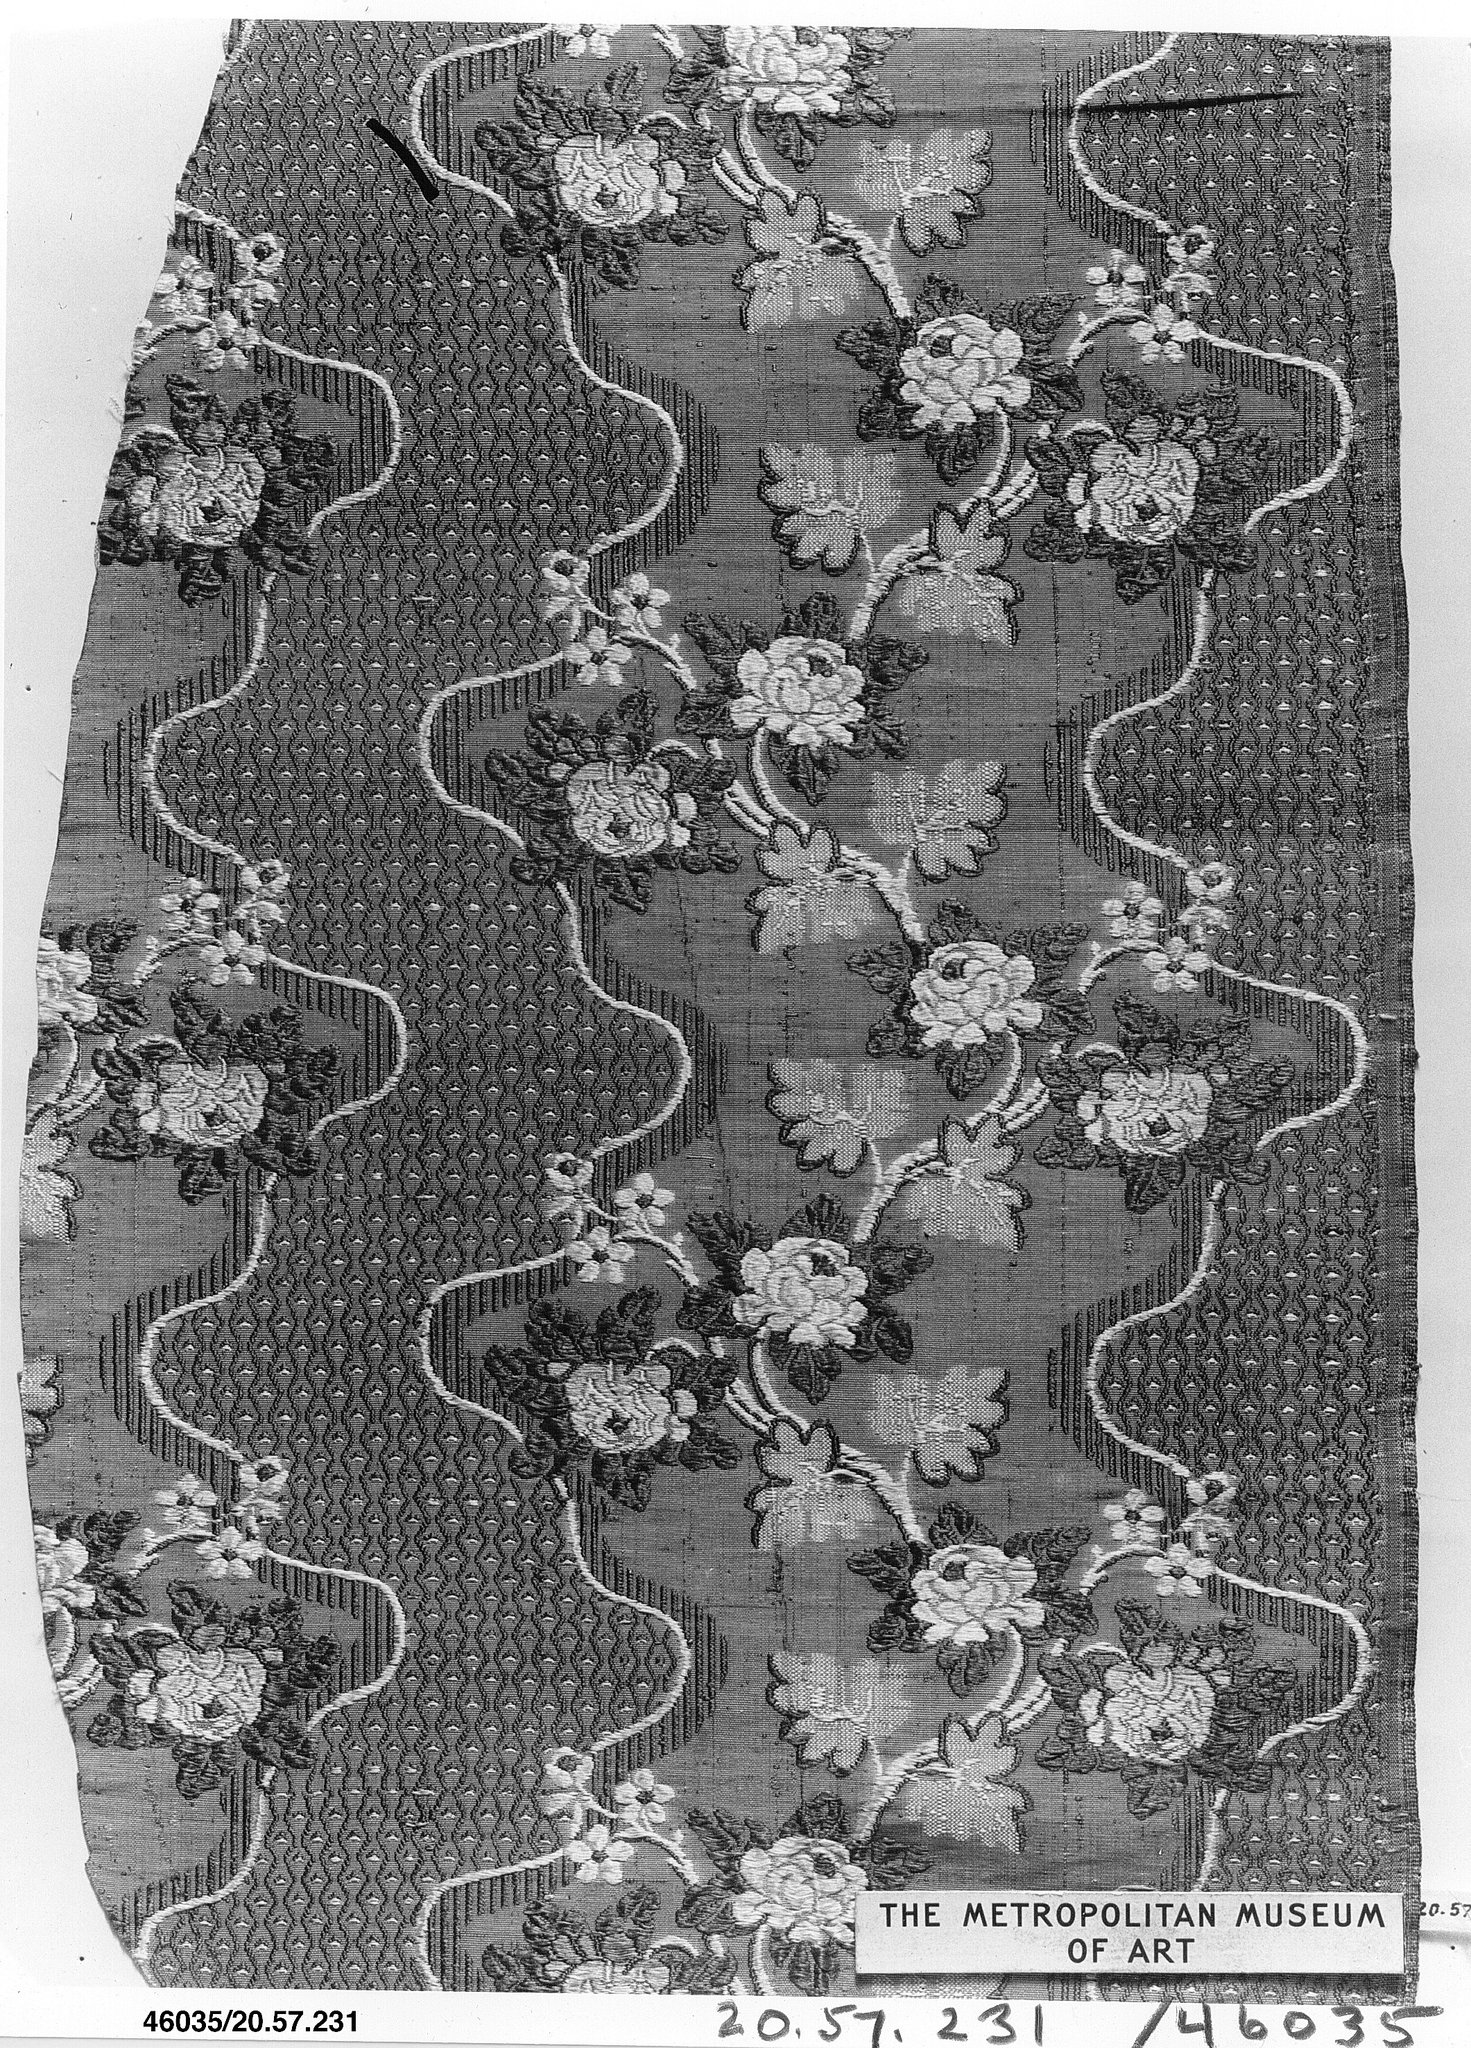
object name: piece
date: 1750-1760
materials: silk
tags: flowers,leaves